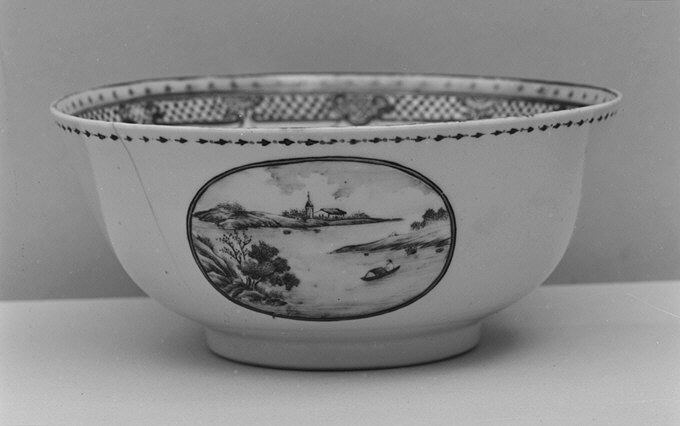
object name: bowl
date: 1776-1800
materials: hard paste porcelain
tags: landscapes